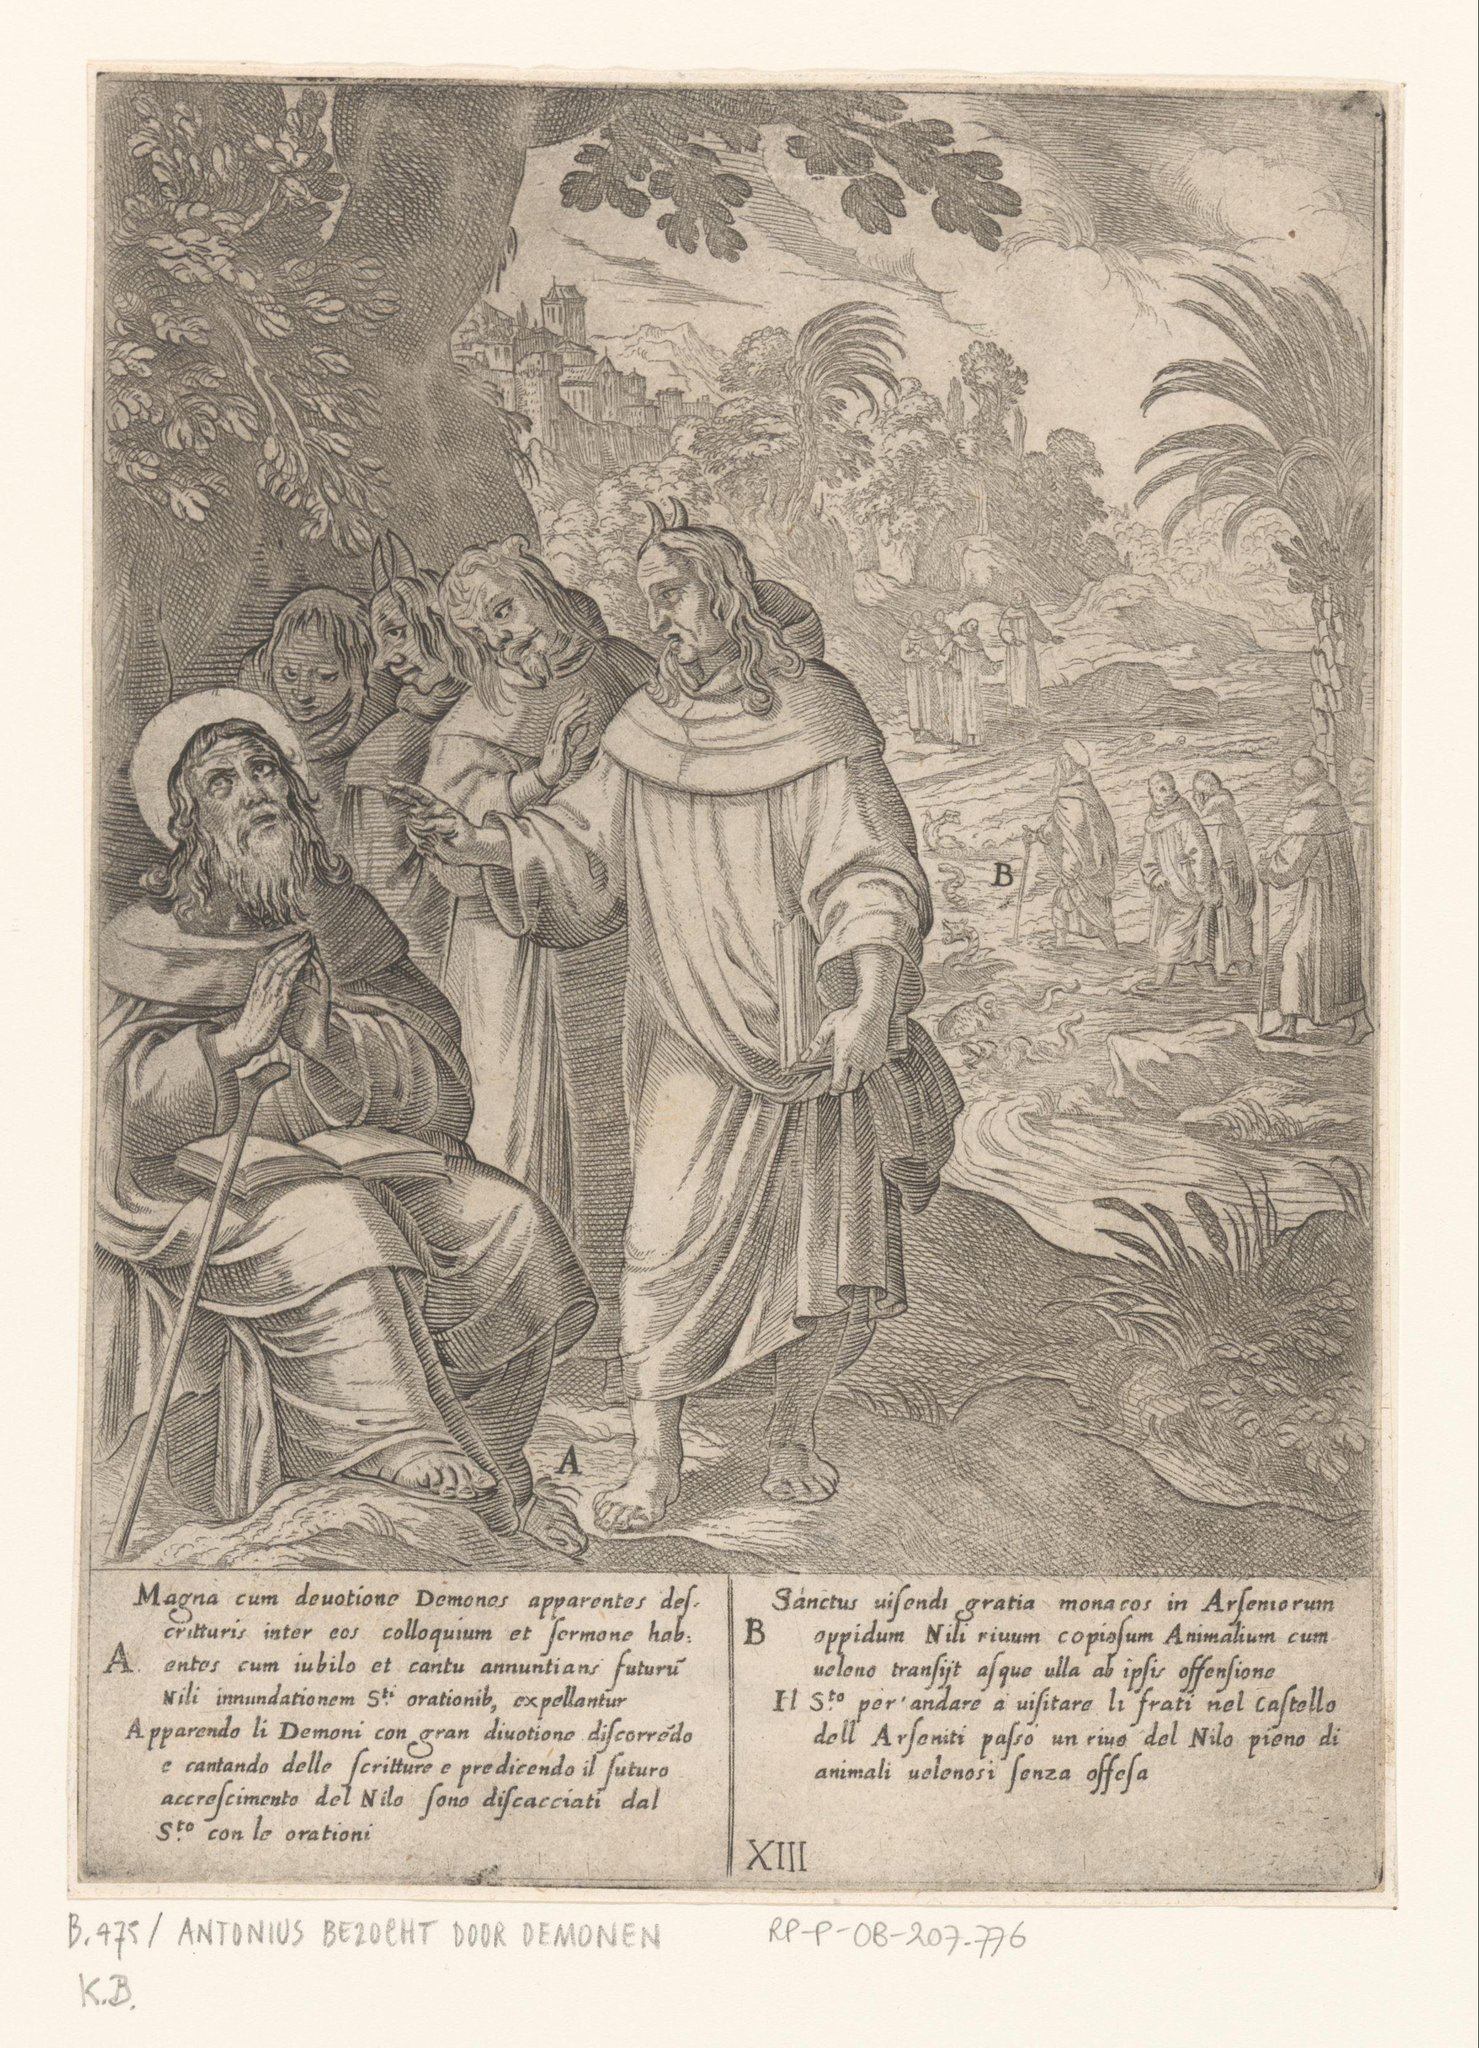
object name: print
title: H. Antonius bezocht door demonen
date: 1598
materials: paper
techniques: etching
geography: rome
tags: the hermit antony abbot (antonius abbas) of egypt, also called the great; possible attributes: bell, book, t-shaped staff, flames, pig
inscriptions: collector's mark: Lugt 240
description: Deze prent maakt deel uit van een reeks van 27 prenten (+ titelprent) over het leven van de heilige Antonius, naar een frescocyclus in de S. Antonio Abbate in Rome door Giovanni Battista Lombardelli en Niccolò Circignani.